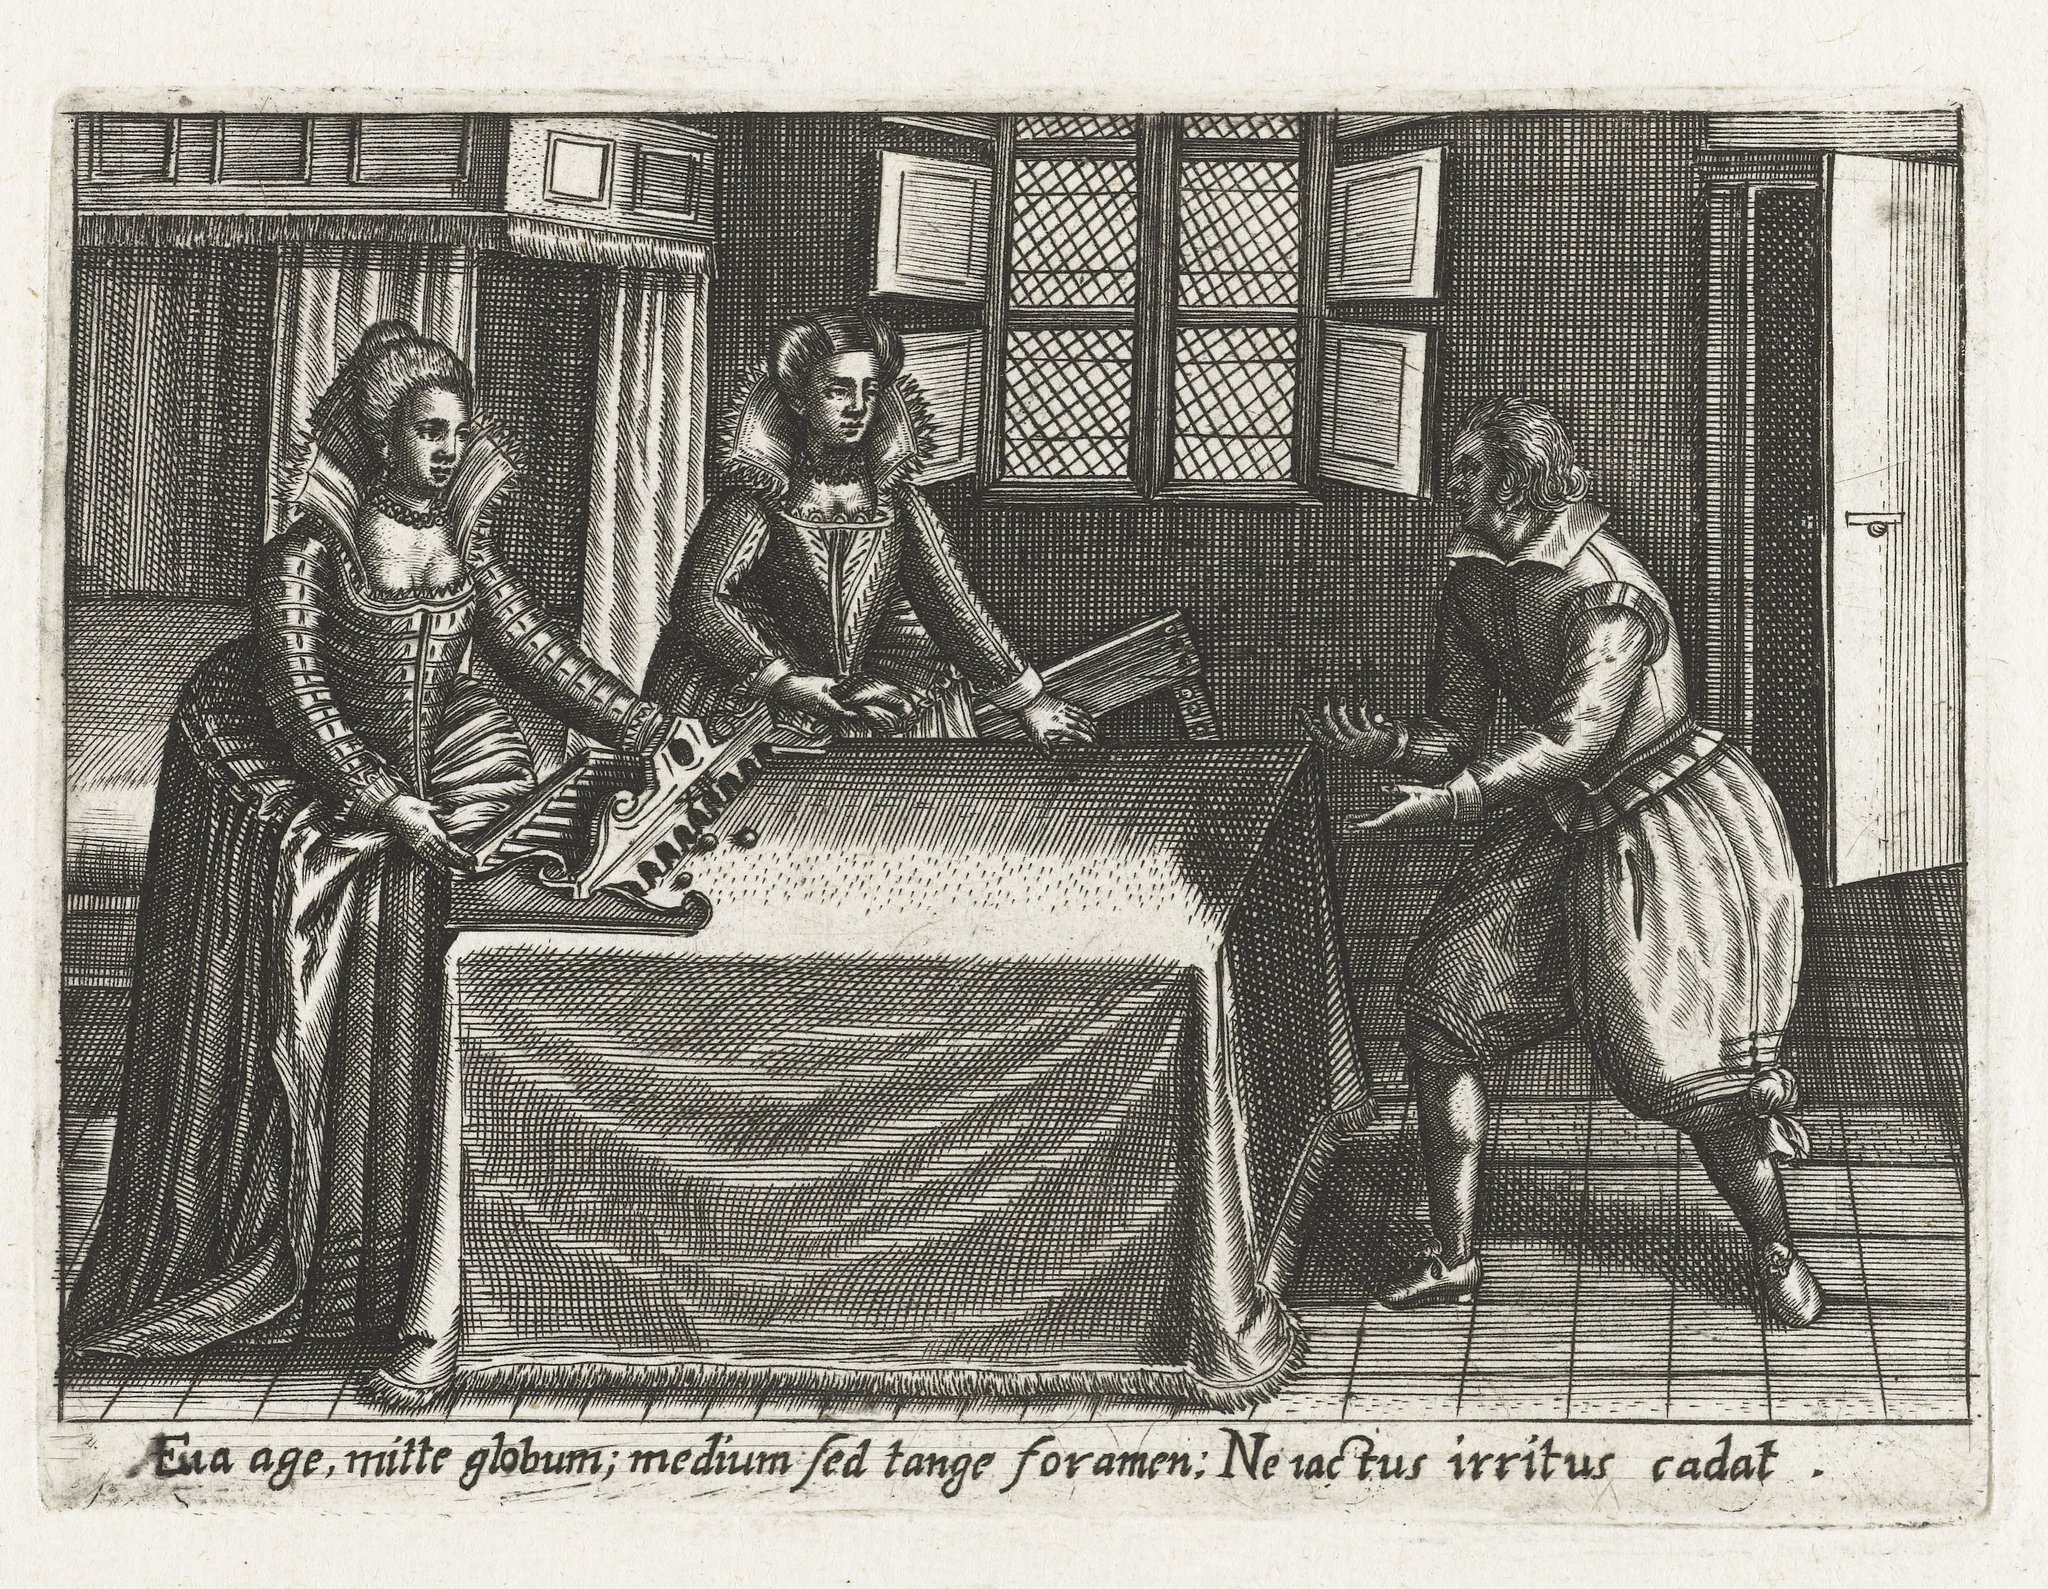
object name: print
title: Twee vrouwen en een man spelen een balspel op tafel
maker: jacob van der heyden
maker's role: draughtsman, print maker, publisher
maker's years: 1573-1645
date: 1608-1618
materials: paper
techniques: engraving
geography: straatsburg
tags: 'album amicorum', 'stammbuch', morality, ball games in which ball or bowl is rolled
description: Deze serie, getiteld ‘Pugillus facetiarum iconographicarum in studiosorum (…)’, bestond vermoedelijk uit 36 of meer prenten. Van deze serie zijn in ieder geval twee uitgaven bekend, uit 1608 en 1618. De prenten uit deze serie in de collectie van het Rijksmuseum (RP-P-1996-1 t/m RP-P-1996-36) zijn vermoedelijk afkomstig uit verschillende uitgaven, of uit de tweede uitgave. De inhoud van beide uitgaven verschilt, maar om de precieze inhoud van de verschillende uitgaven vast te stellen is meer onderzoek nodig. Er zijn geen volledige exemplaren van de eerste uitgave bekend. Aan de hand van de analyse van een andere serie, ‘Jeucht spieghel’,* die kopieën van ‘Pugillus’ bevat en is uitgegeven in 1610 én de aanwezige exemplaren van prenten uit ‘Pugillus’ in een inmiddels verloren album amicorum uit 1610,** kan in ieder geval van een aantal prenten gesteld worden dat ze al voorkwamen in de uitgave van 1608. Dit geldt voor RP-P-1996-1 (de titelprent), RP-P-1996-5, RP-P-1996-6, RP-P-1996-7, RP-P-1996-8, RP-P-1996-9, RP-P-1996-10, RP-P-1996-11, RP-P-1996-12, RP-P-1996-13, RP-P-1996-14, RP-P-1996-15, RP-P-1996-16, RP-P-1996-17, RP-P-1996-18, RP-P-1996-19, RP-P-1996-24, RP-P-1996-28, RP-P-1996-29, RP-P-1996-33 en RP-P-1996-35. Van één prent (RP-P-1996-31) kan vastgesteld worden dat die pas in de latere uitgave van 1618 voorkwam, omdat het kopie is van een prent uit weer een andere serie, ‘Academia sive speculum vitae scholasticae (…)’, die werd uitgegeven in 1612.*** Van de huidige prent is onduidelijk of hij al voorkwam in de uitgave van 1608. * Z.G.H.P.H.S [Zacharias Heyns]. Jeucht spieghel. S.l.s.n., 1610. Voor een gedigitaliseerd exemplaar zie: https://archive.org/details/ned-kbn-all-00000628-001/page/n9/mode/2up. ** Zie: Erman, Wilhelm en Ewald Horn. Bibliographie der deutschen Universitäten, systematisch geordnetes Verzeichnis der bis Ende 1899 gedruckten Bücher und Aufsätze über das deutsche Universitätswesen. Leipzig en Berlijn: Verlag von B.G. Teubner, 1904, dl. 1, p. 826-832, no. 17328. https://archive.org/details/bibliographieder01ermauoft/page/826/mode/2up *** Passe, Crispijn van de (I). Academia sive speculum vitae scholasticae (…). Arnhem: Johannes Janssonius [Jan Jansz.], 1612. Voor een gedigitaliseerd exemplaar zie: http://gallica.bnf.fr/ark:/12148/btv1b55005974h.